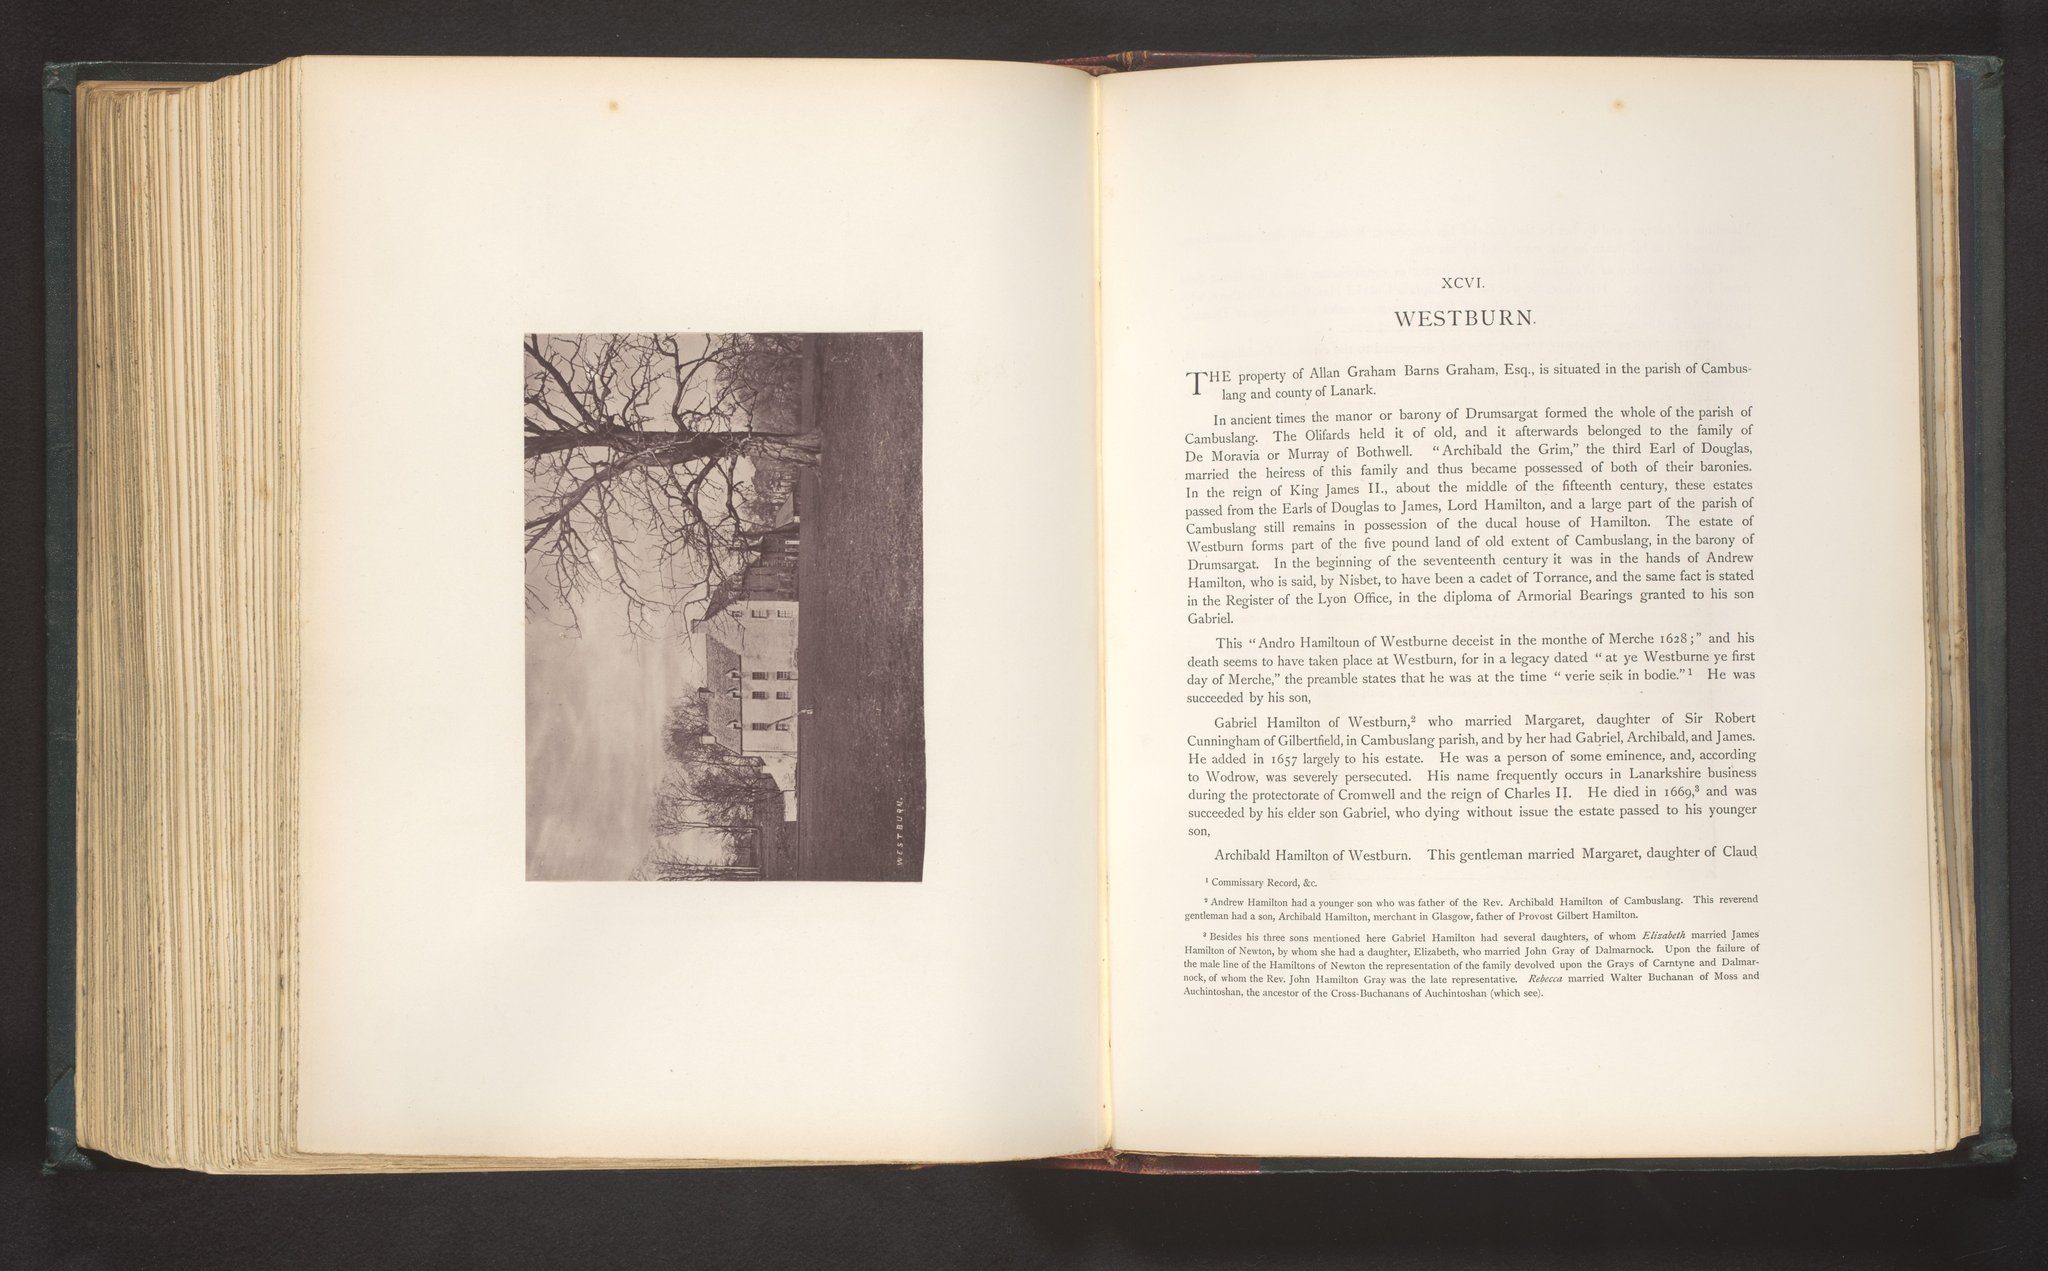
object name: photograph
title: Westburn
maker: thomas annan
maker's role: fotograaf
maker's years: 1829-1887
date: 1868-1878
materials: paper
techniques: carbon print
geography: scotland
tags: rural housing, e.g. country-house, villa, cottage, façade (of house or building)